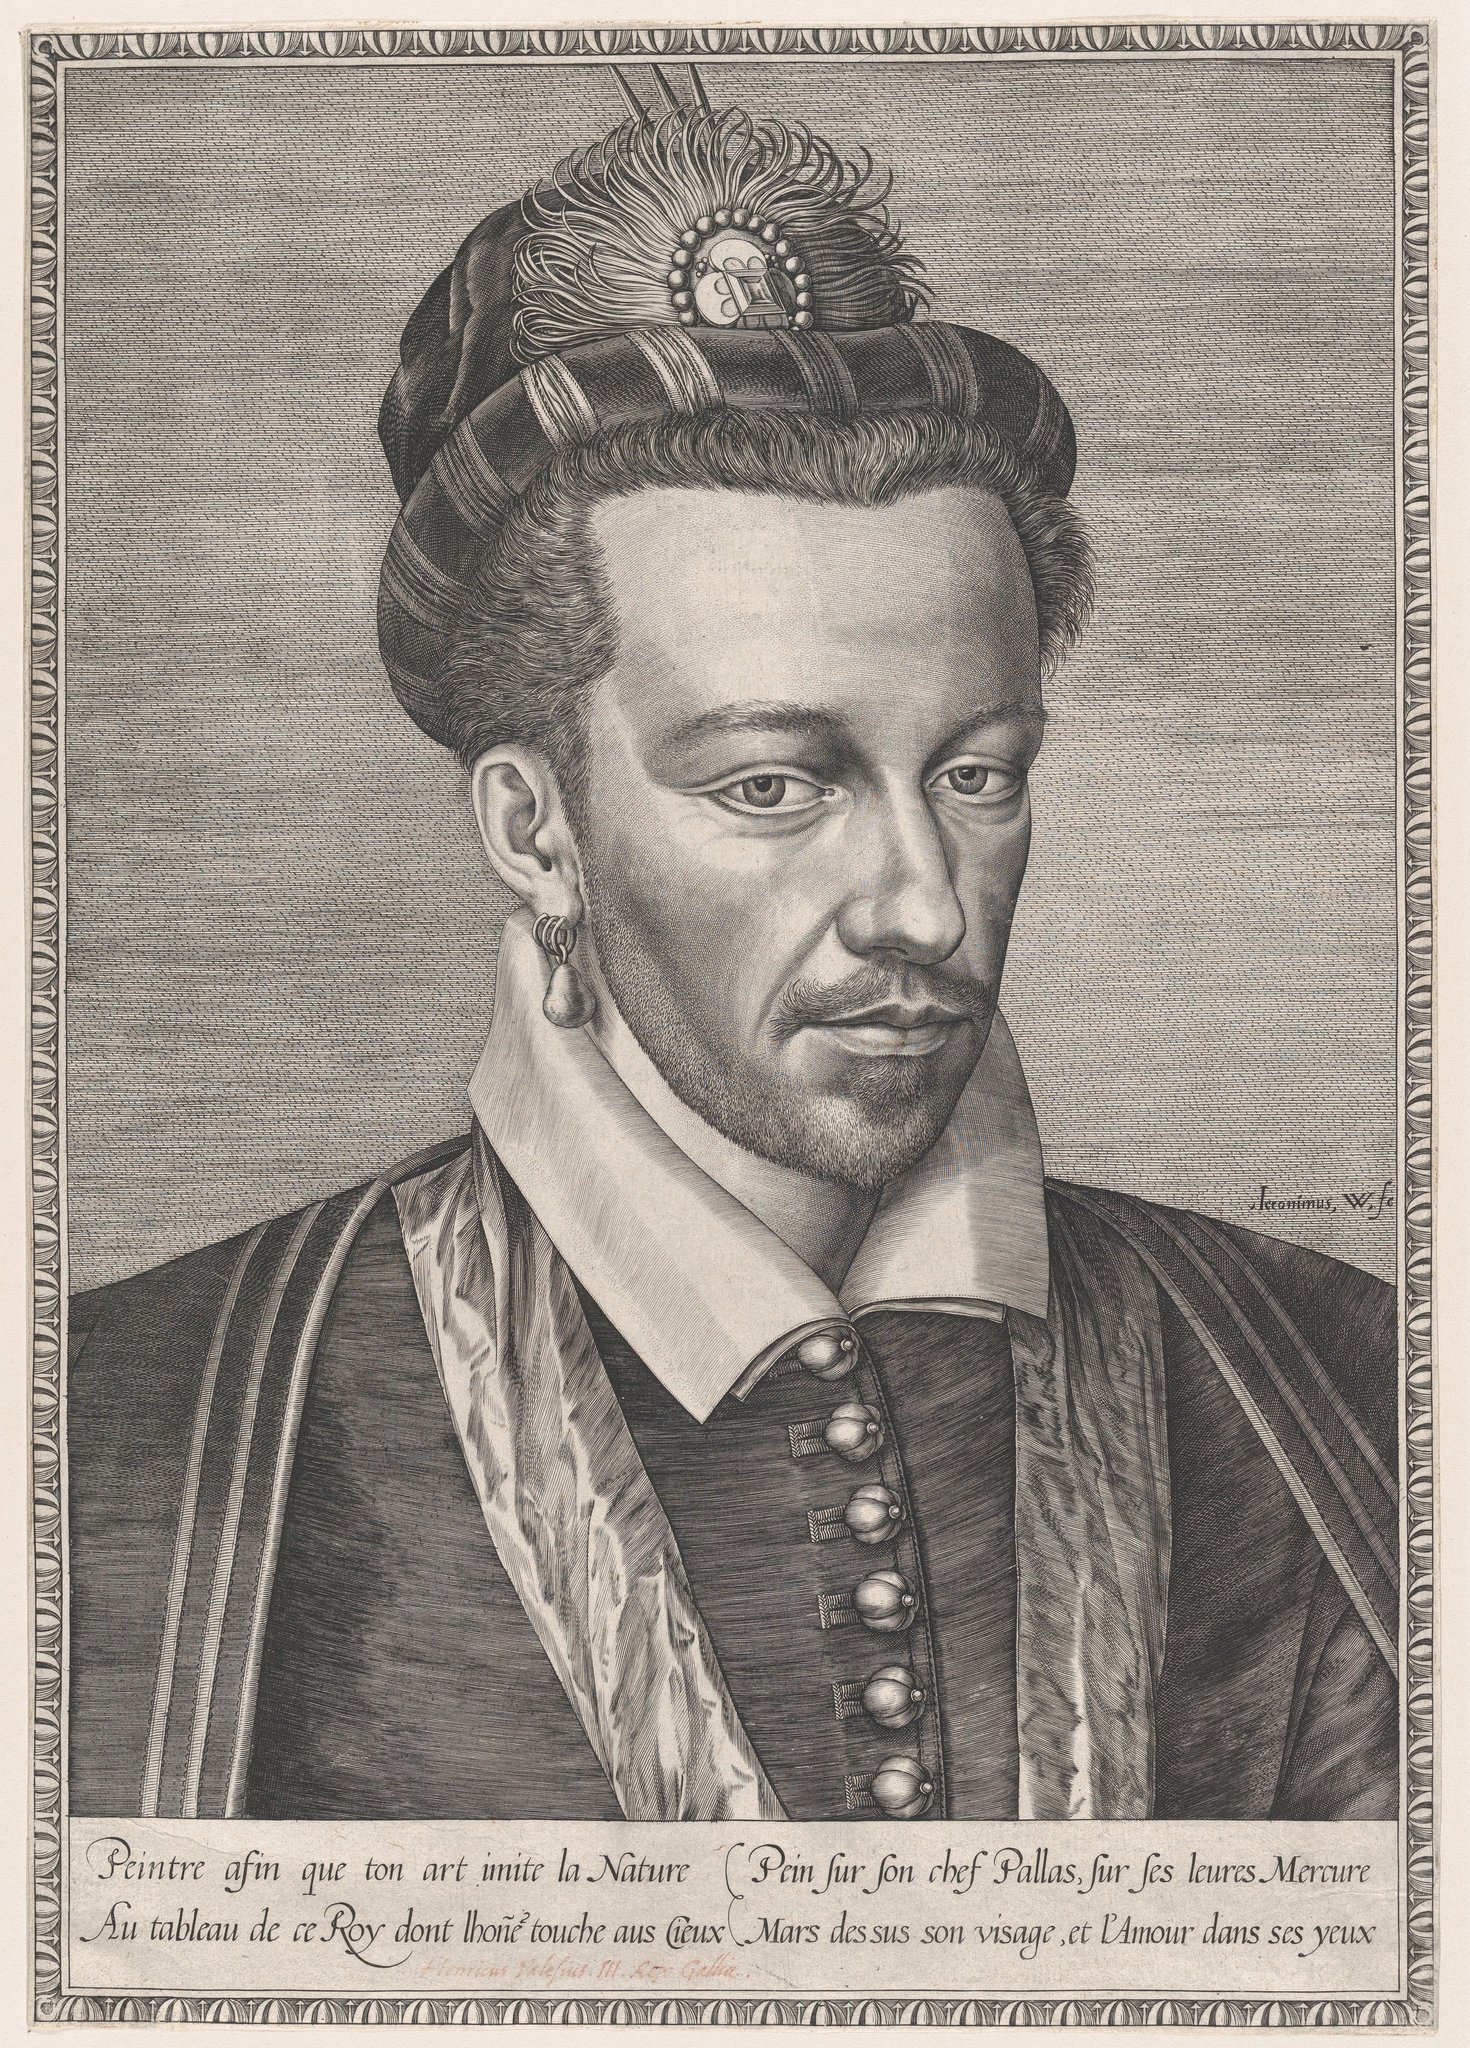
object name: print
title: Henri III, King of France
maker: hieronymus wierix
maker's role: artist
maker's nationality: netherlandish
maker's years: 1553-1619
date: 1582-1586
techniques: engraving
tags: kings,portraits